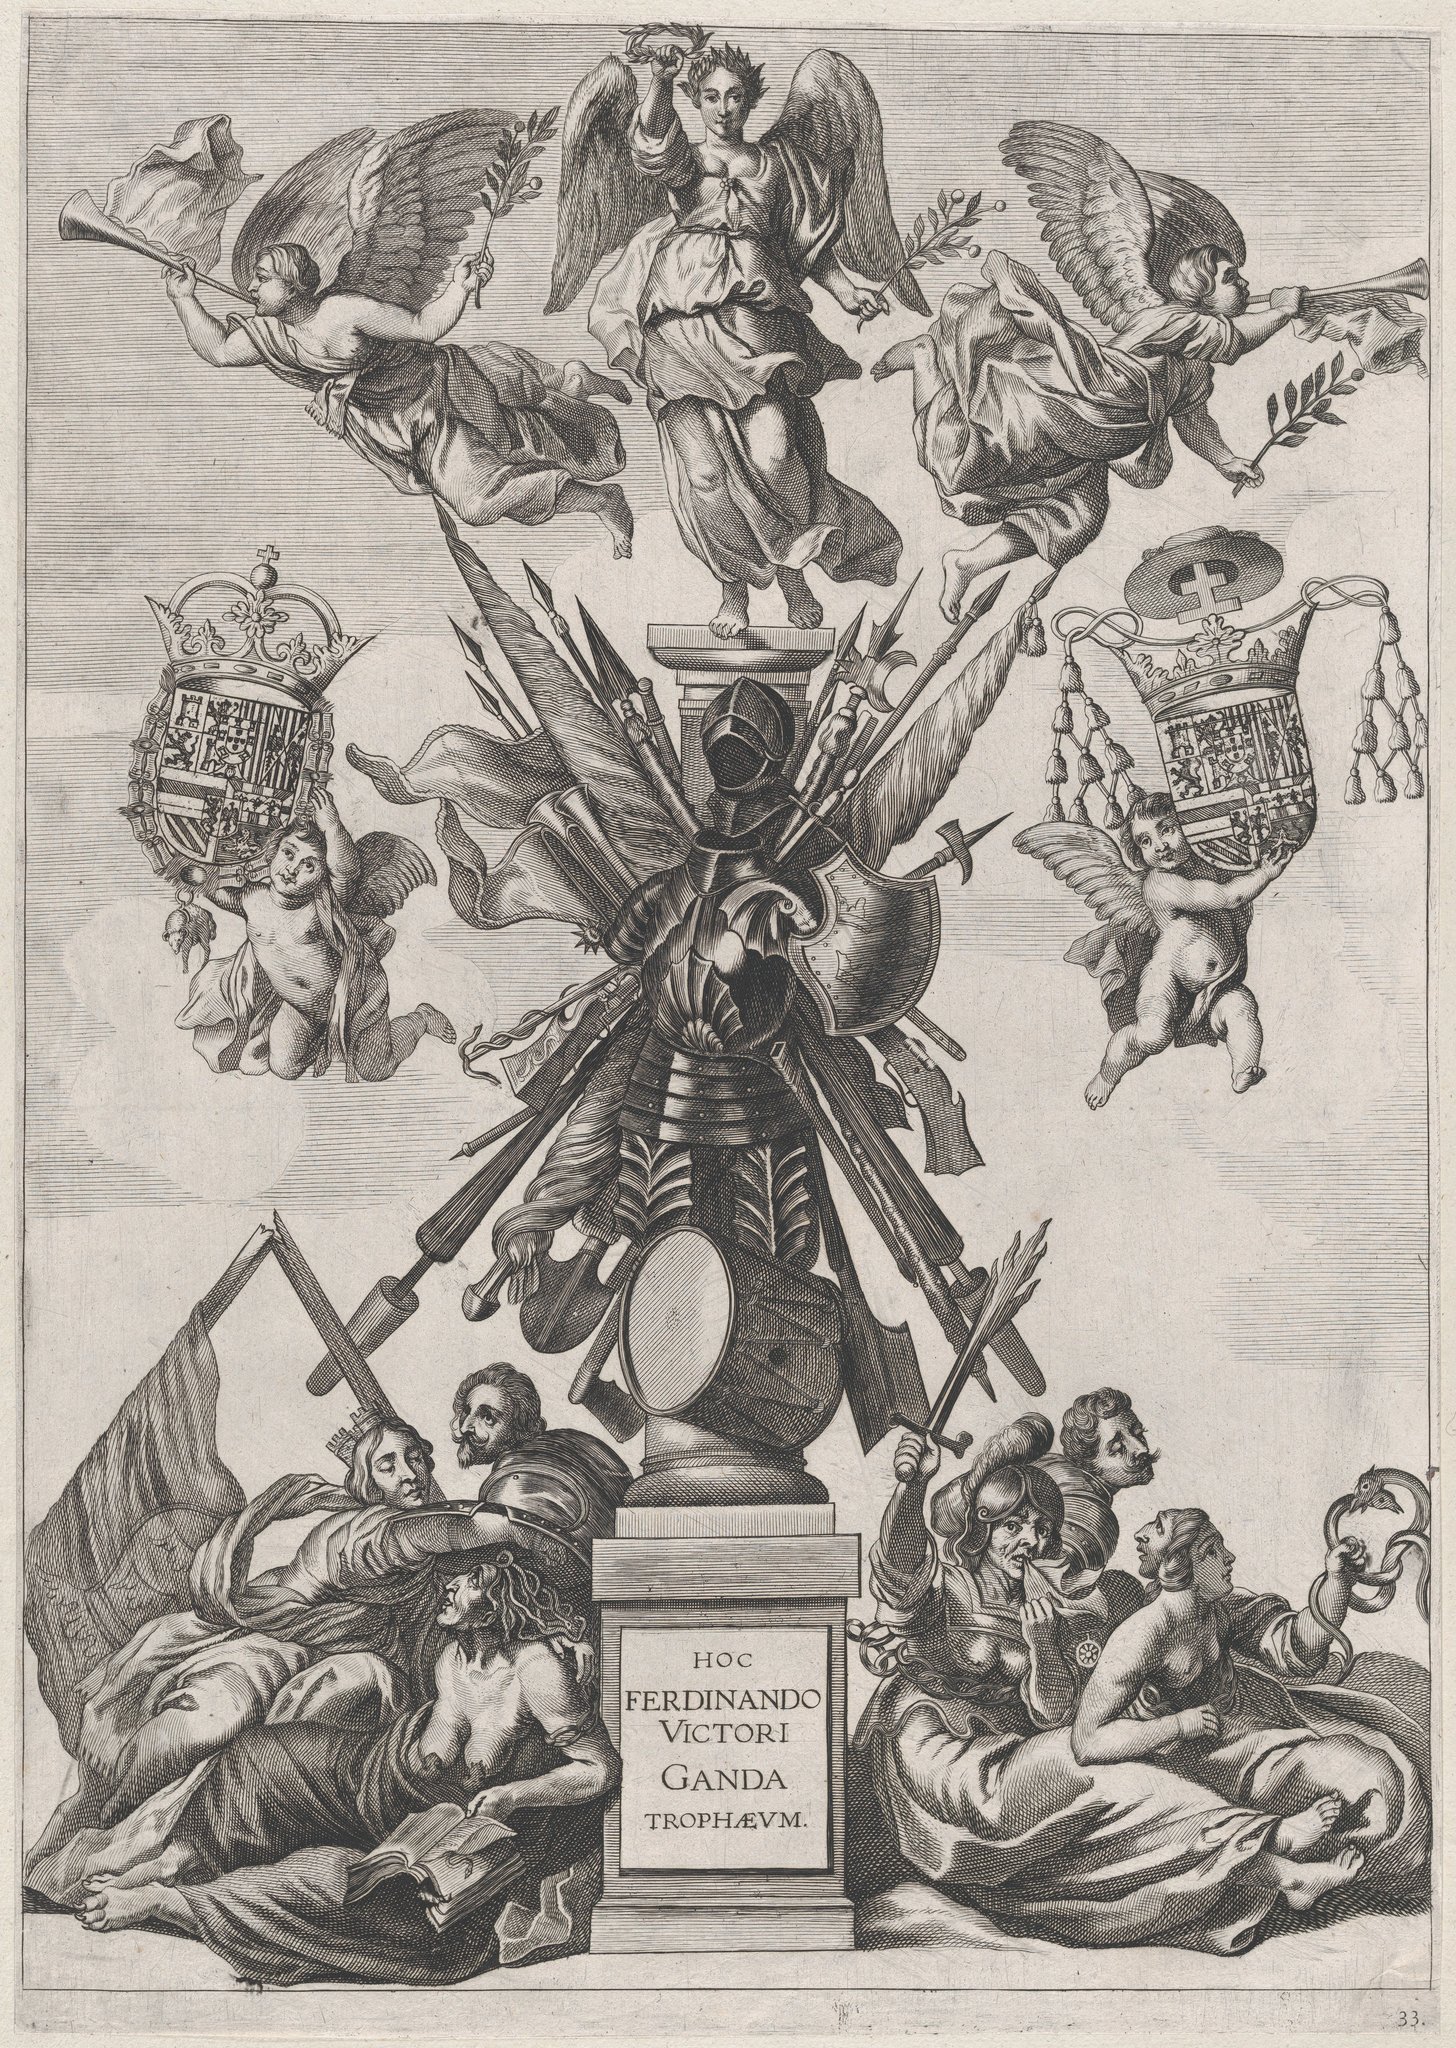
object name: print, fete, ornament architecture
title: Plate 33: Armorial trophy on a Tuscan column, surrounded by allegorical figures and cherubs bearing the armorial shields of Ferdinand; from Guillielmus Becanus's 'Serenissimi Principis Ferdinandi, Hispaniarum Infantis...'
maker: johannes meursius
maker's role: publisher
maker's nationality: flemish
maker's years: 1600-1699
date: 1636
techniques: engraving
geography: antwerp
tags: armor,coat of arms,trophies